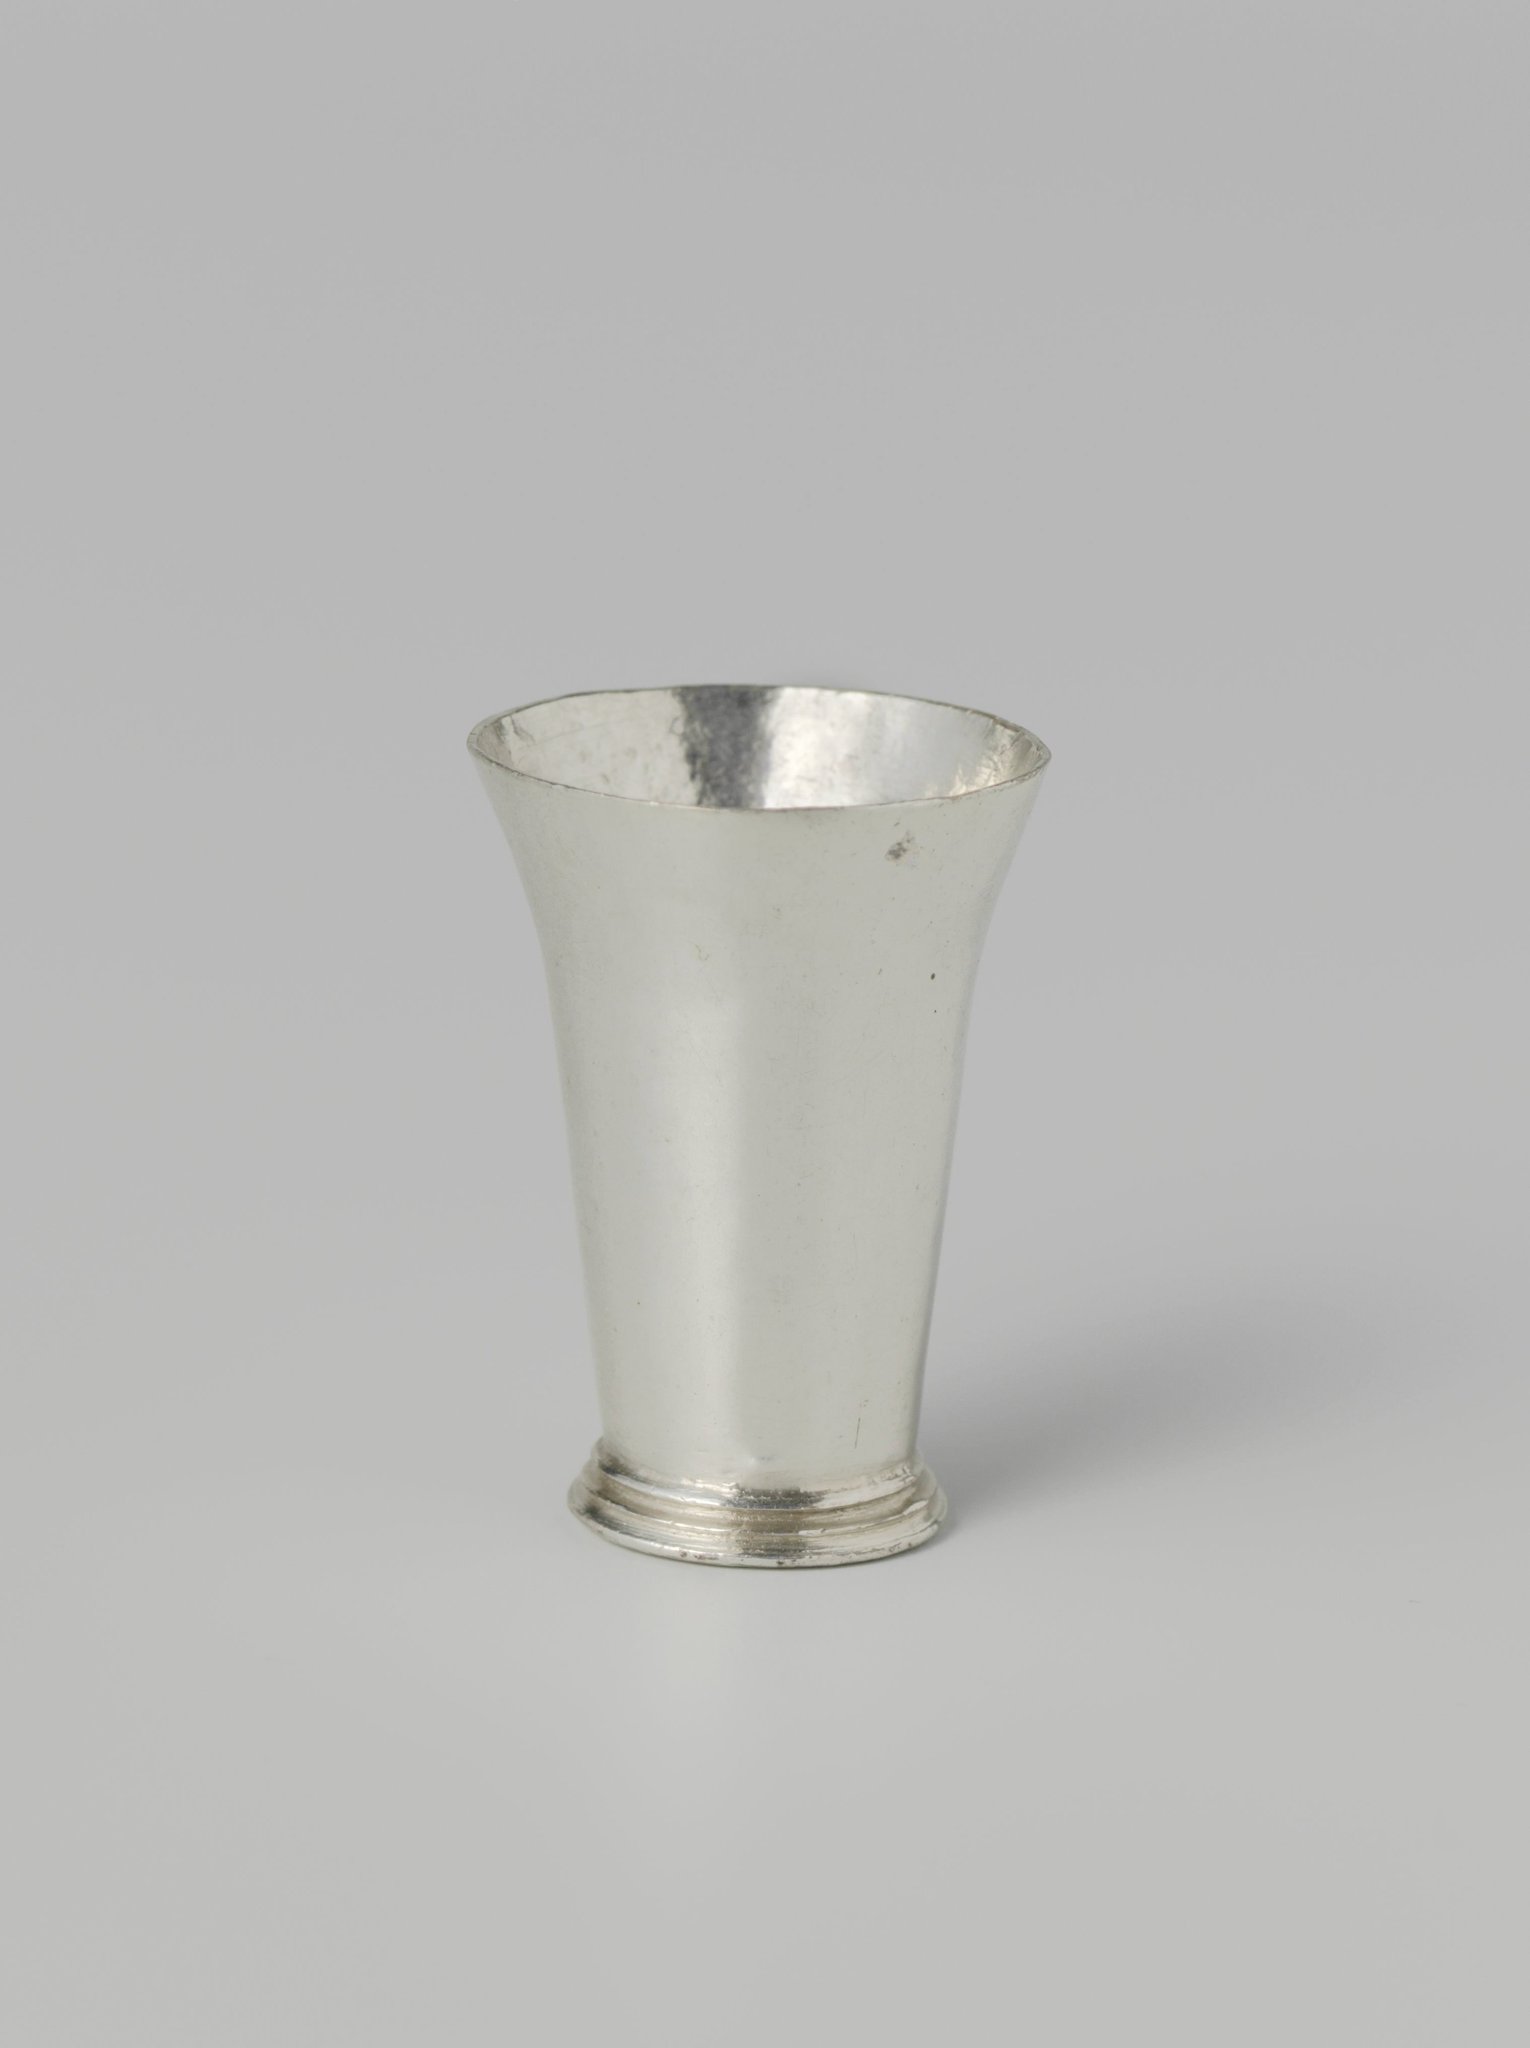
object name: miniature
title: Beker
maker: Anonymous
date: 1675-1700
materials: silver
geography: netherlands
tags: mug, beaker, goblet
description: Beker op een geribbelde voet. De beker loopt naar boven uit en is gemerkt: mt.= W in liggend ovaal en de letter V.